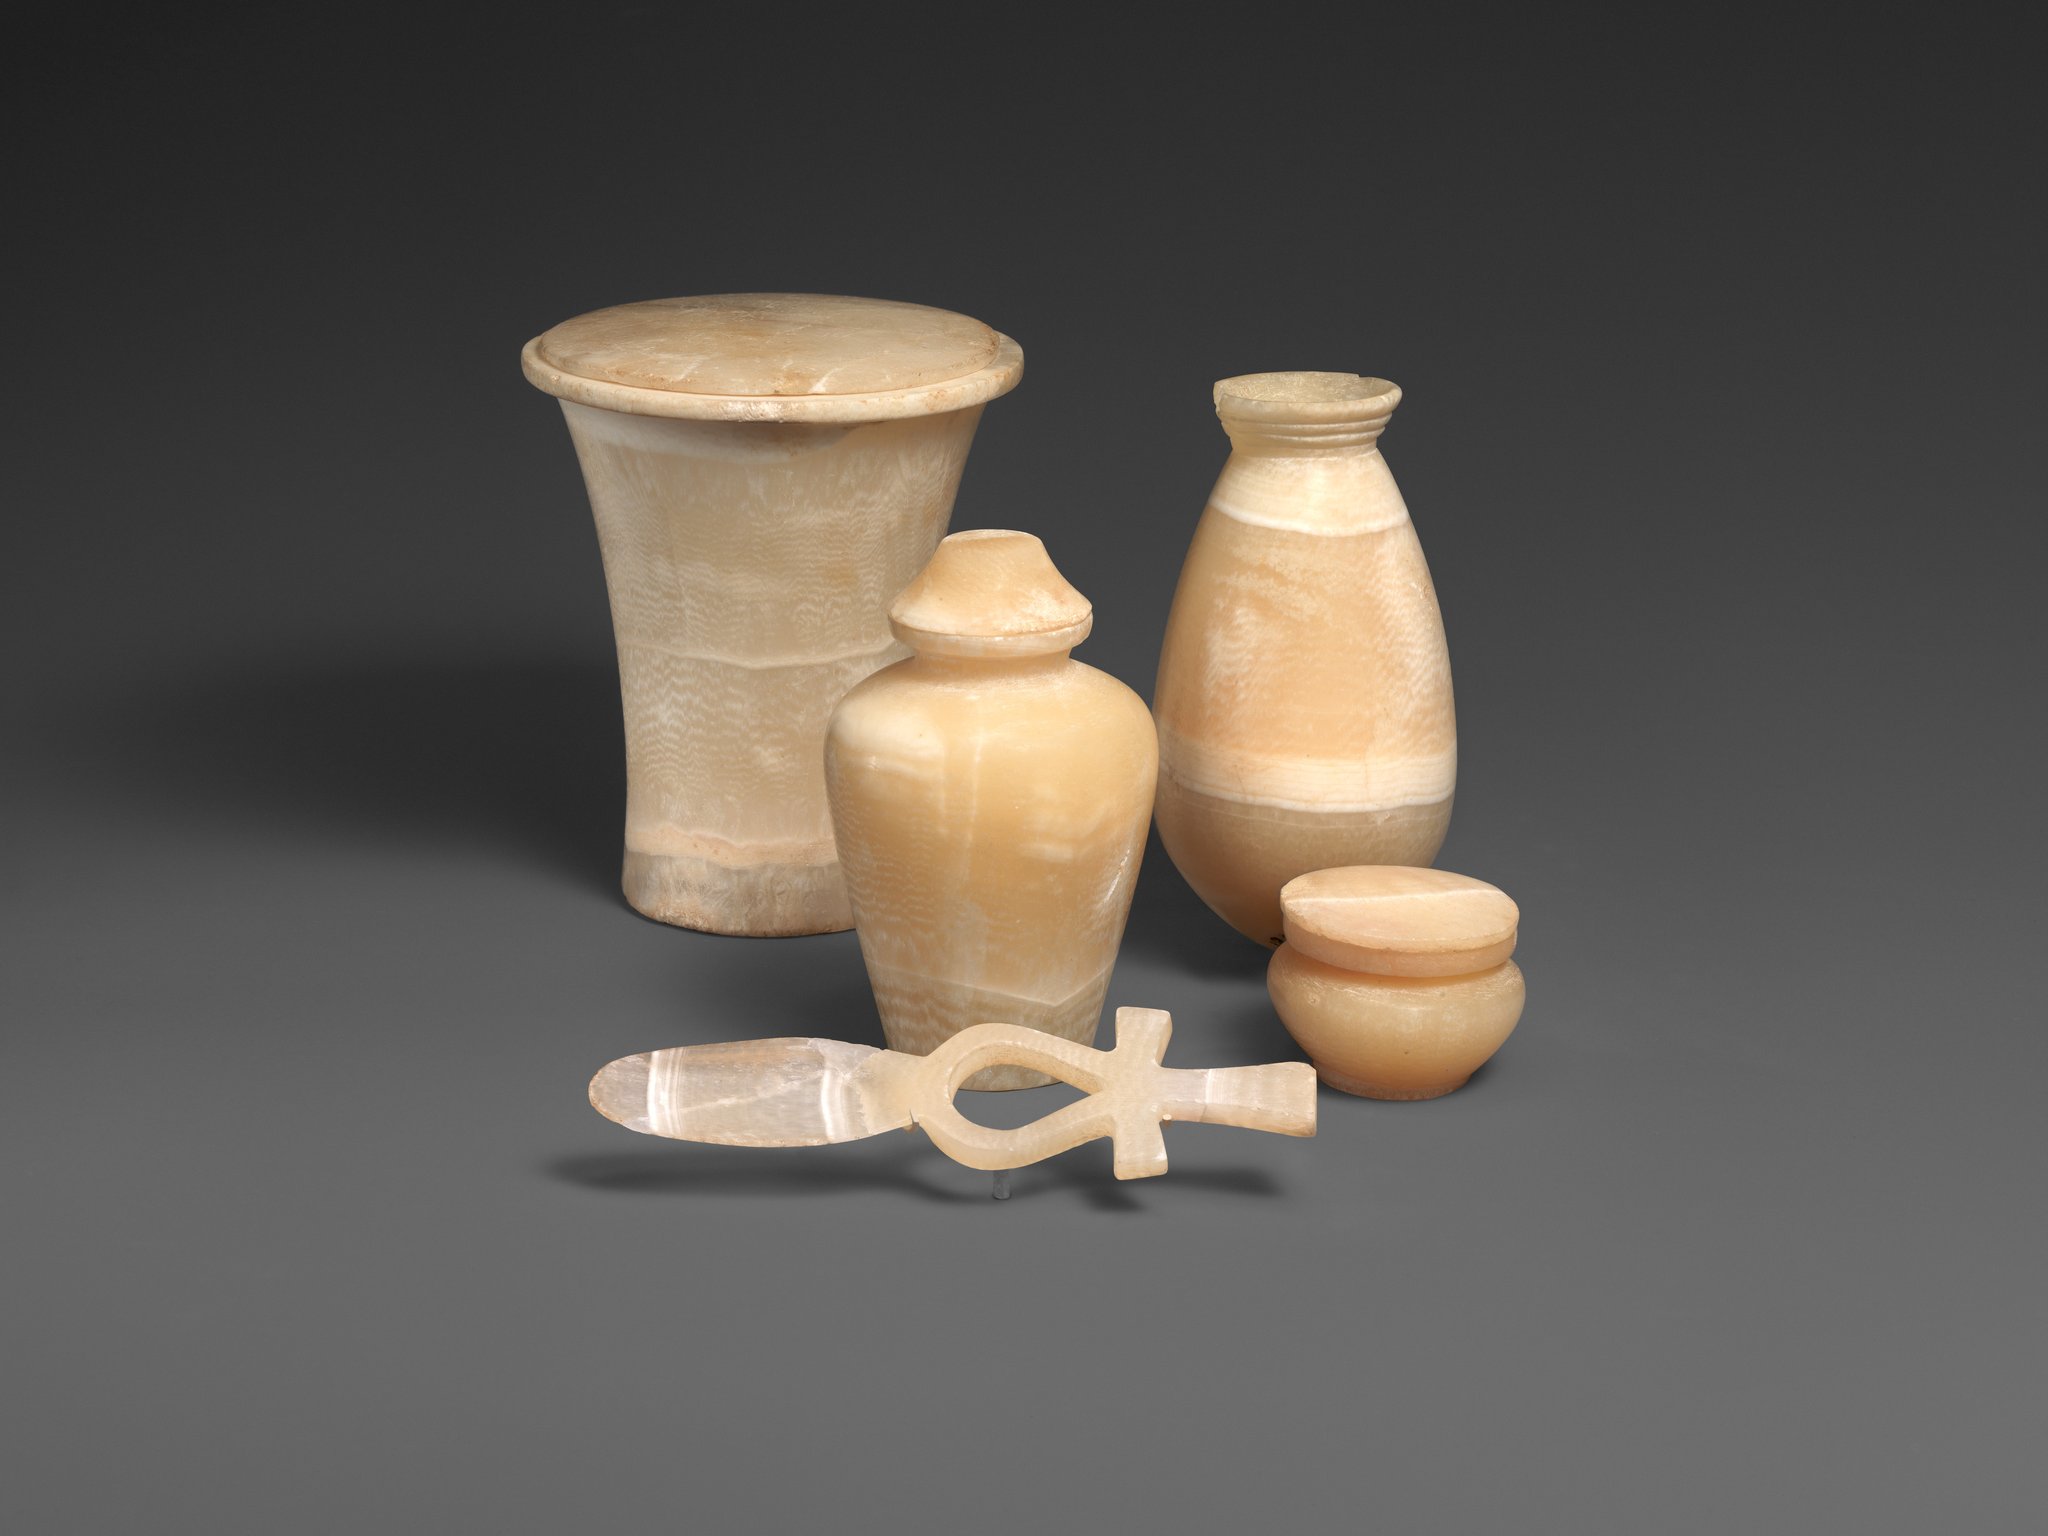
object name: cosmetic vessel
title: A group of stone vessels from a tomb at Haraga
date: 1887-1750 BCE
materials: stone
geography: egypt